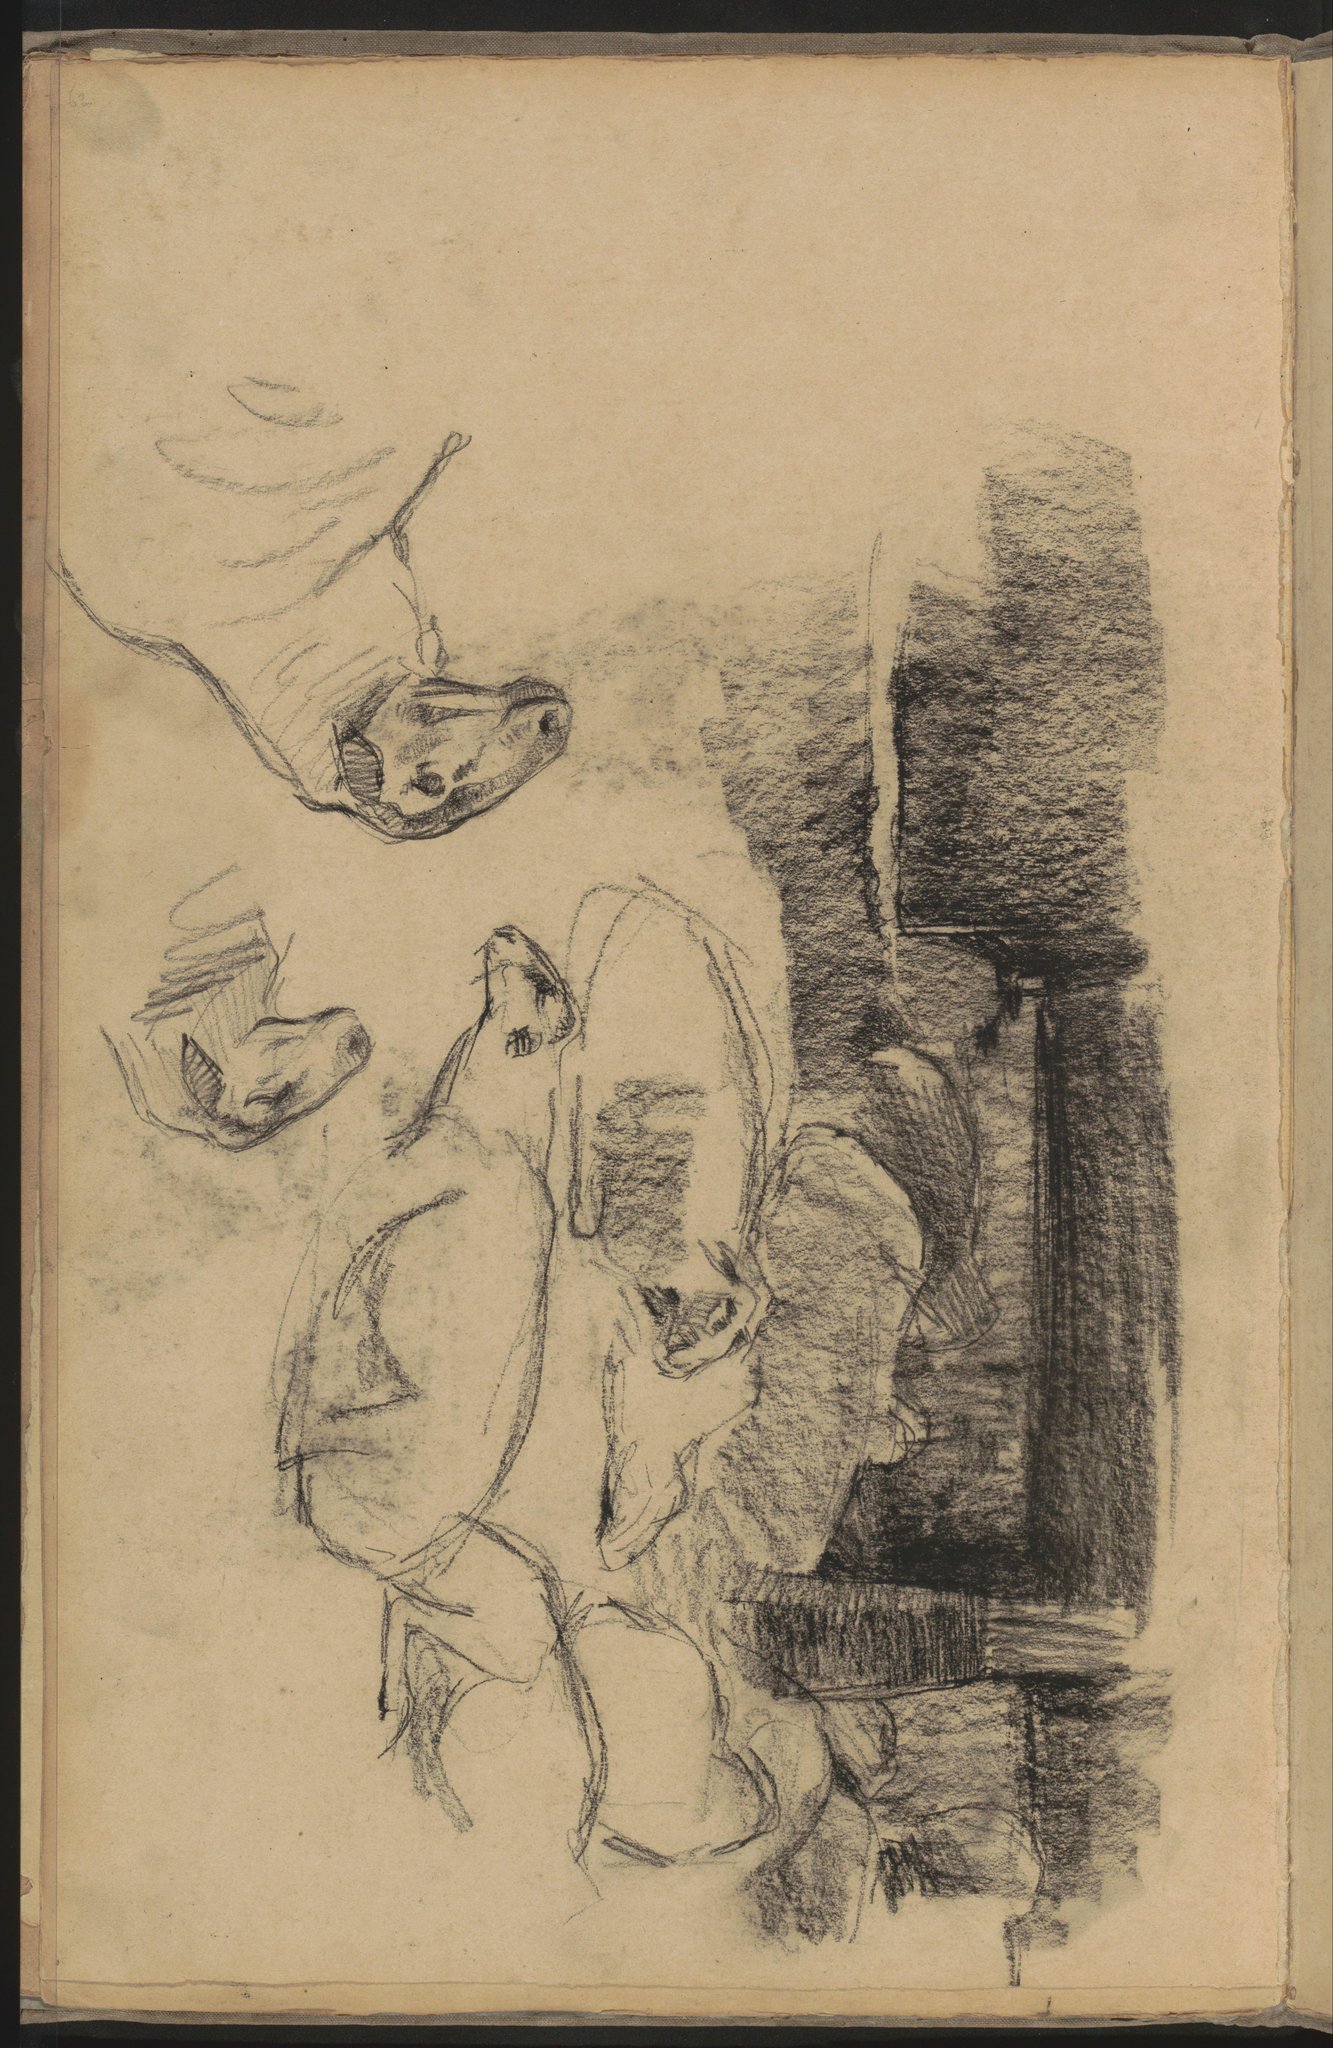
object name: sketchbook leaf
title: Schapenkoppen en een interieur van een schaapskooi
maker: willem witsen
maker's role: draughtsman, painter, print maker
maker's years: 1860-1923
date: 1884-1887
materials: chalk, paper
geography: ewijkshoeve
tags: sheep, stall, stable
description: Pagina 62 uit een schetsboek met 42 bladen vervaardigd rond de Ewijkshoeve.